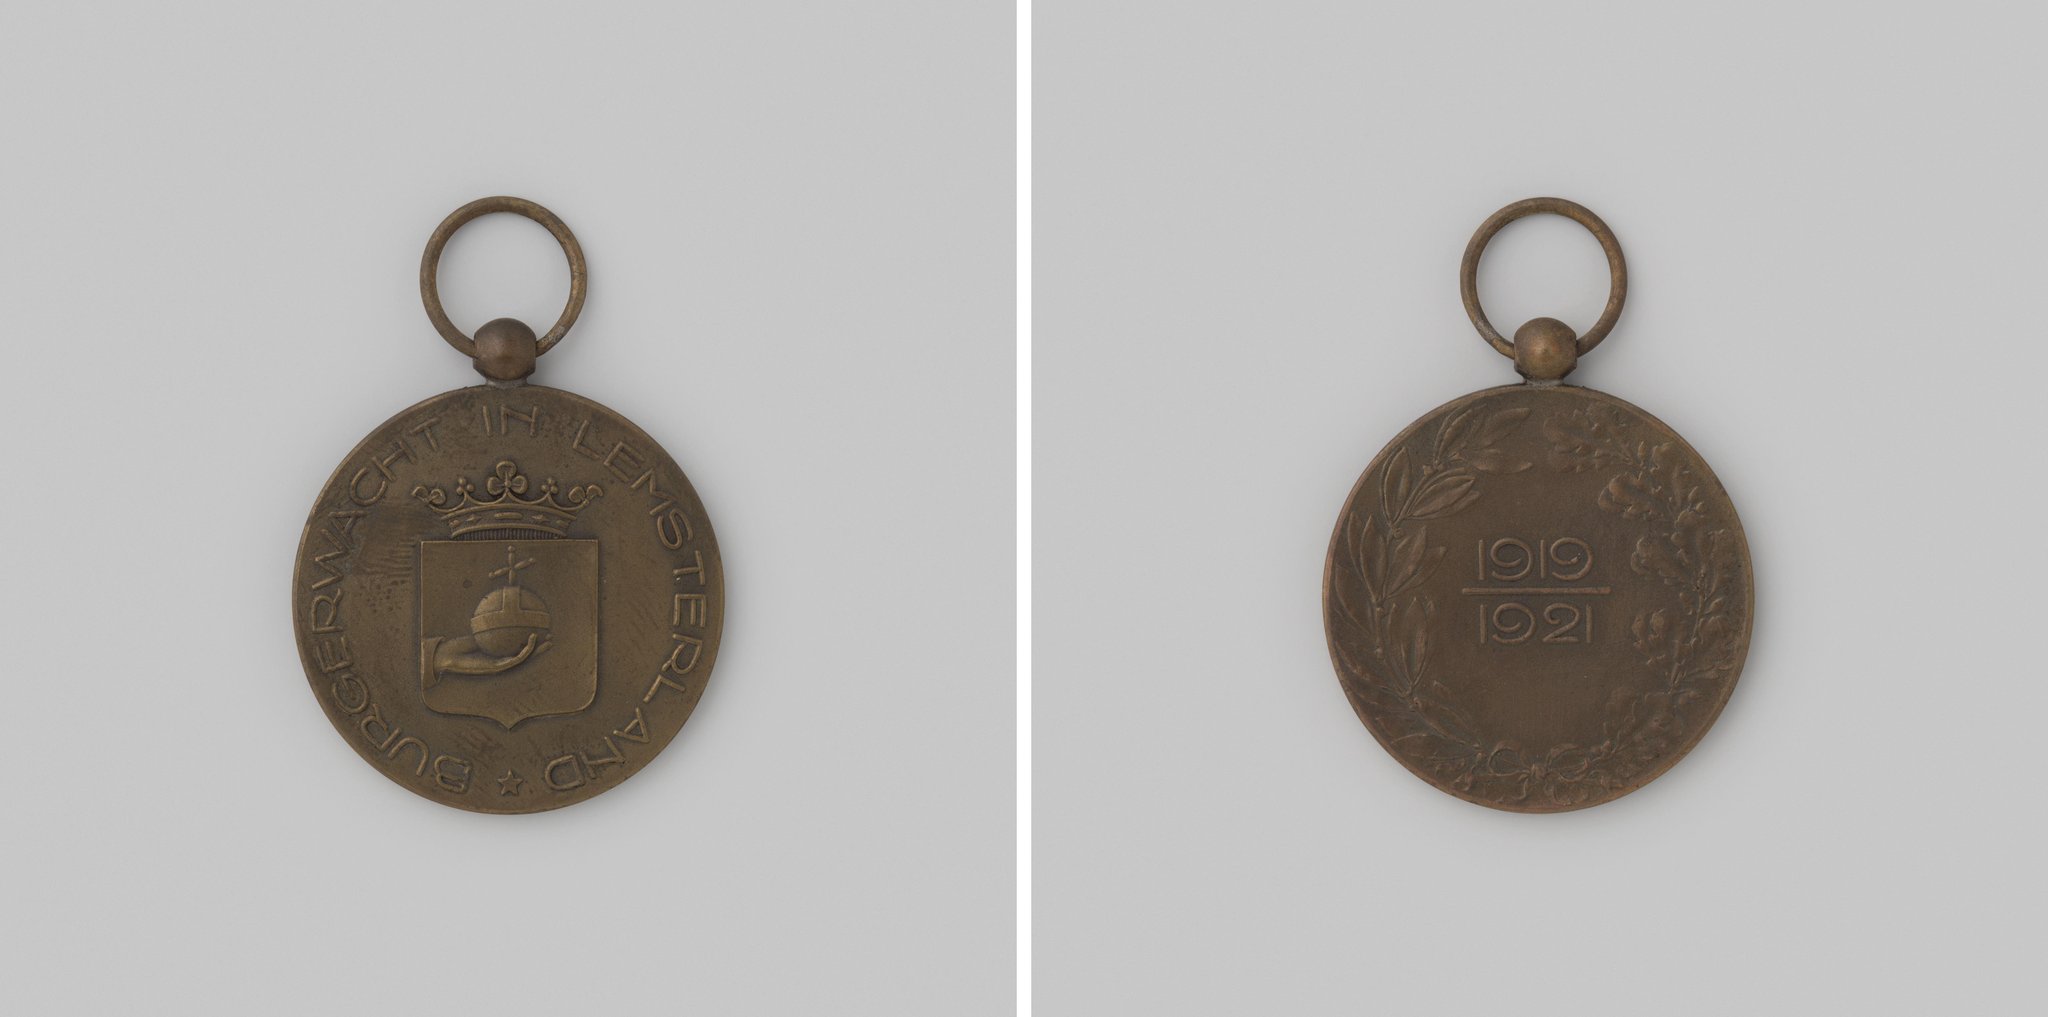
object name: presentiepenning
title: Draagpenning van de burgerwacht in Lemsterland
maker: Anonymous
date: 1919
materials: metal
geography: lemsterland